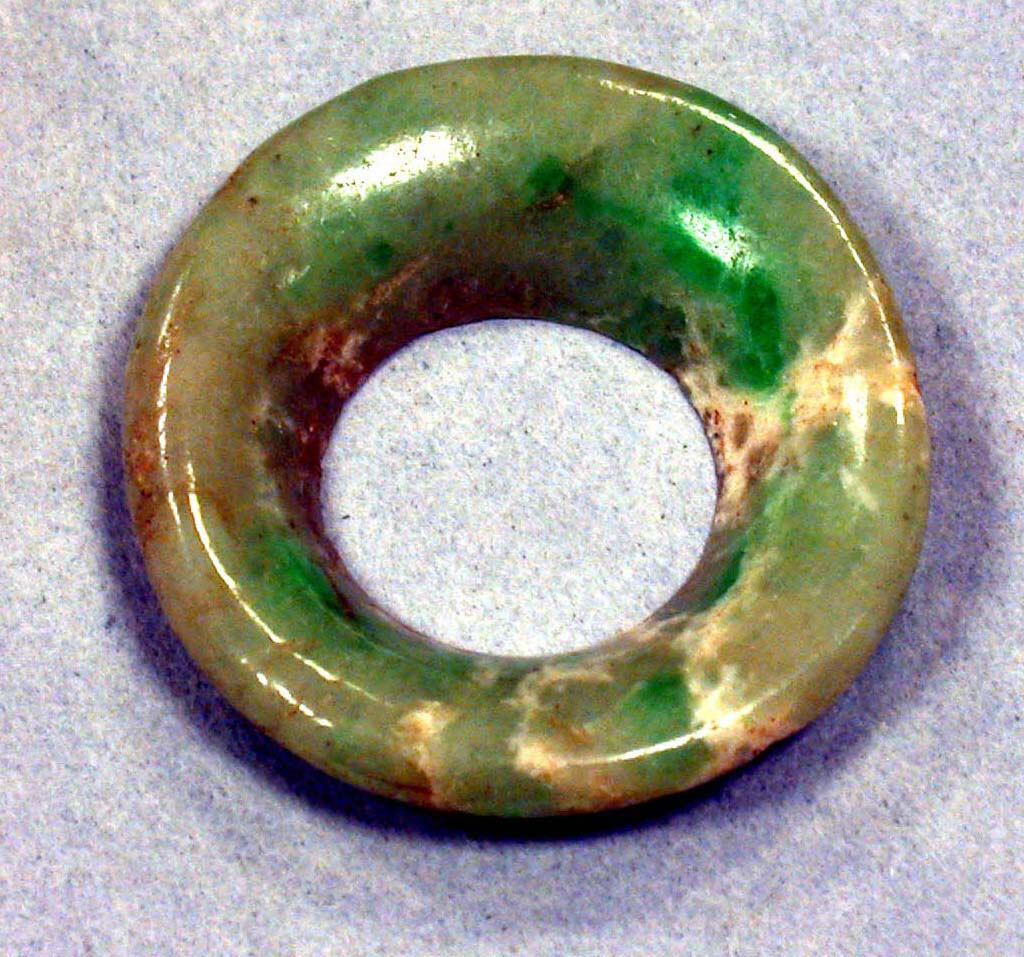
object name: earflare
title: Stone Ear Flare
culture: mexican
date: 1501-1600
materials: jade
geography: mexico